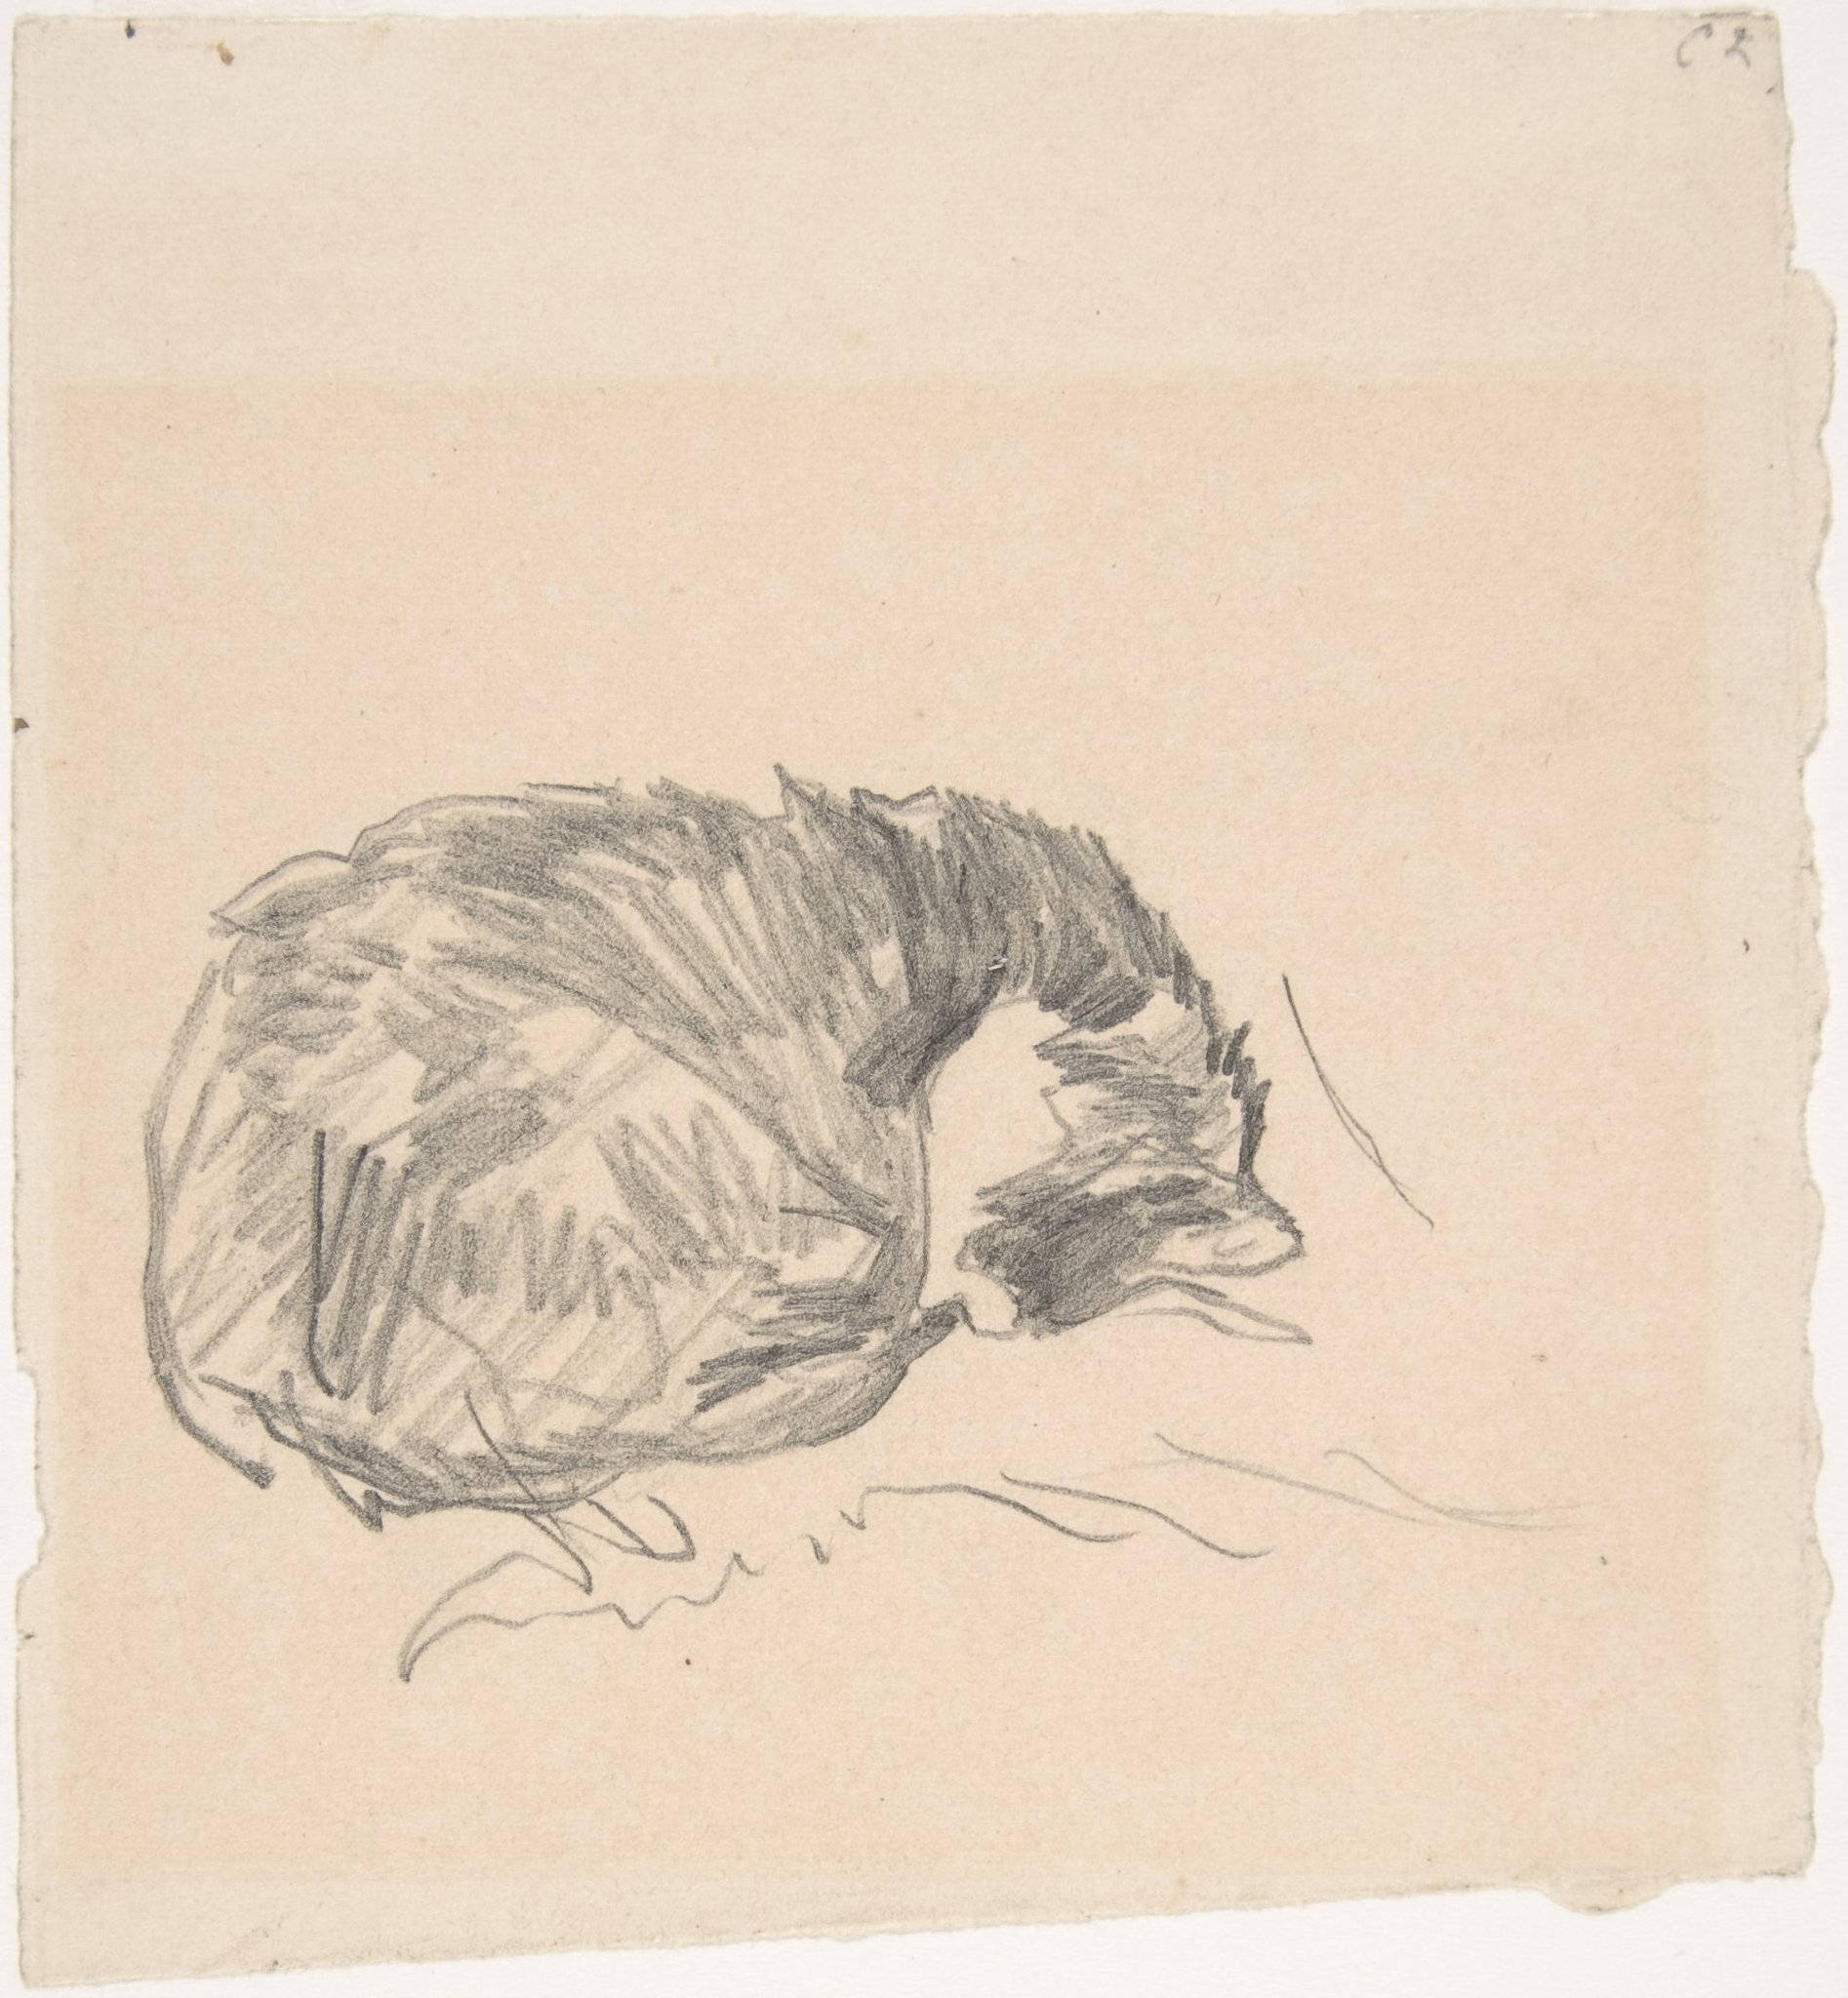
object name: drawing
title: A Cat Curled Up, Sleeping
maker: édouard manet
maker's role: artist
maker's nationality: french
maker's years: 1832-1883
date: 1861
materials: graphite, ivory, paper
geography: france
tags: sleeping,cats